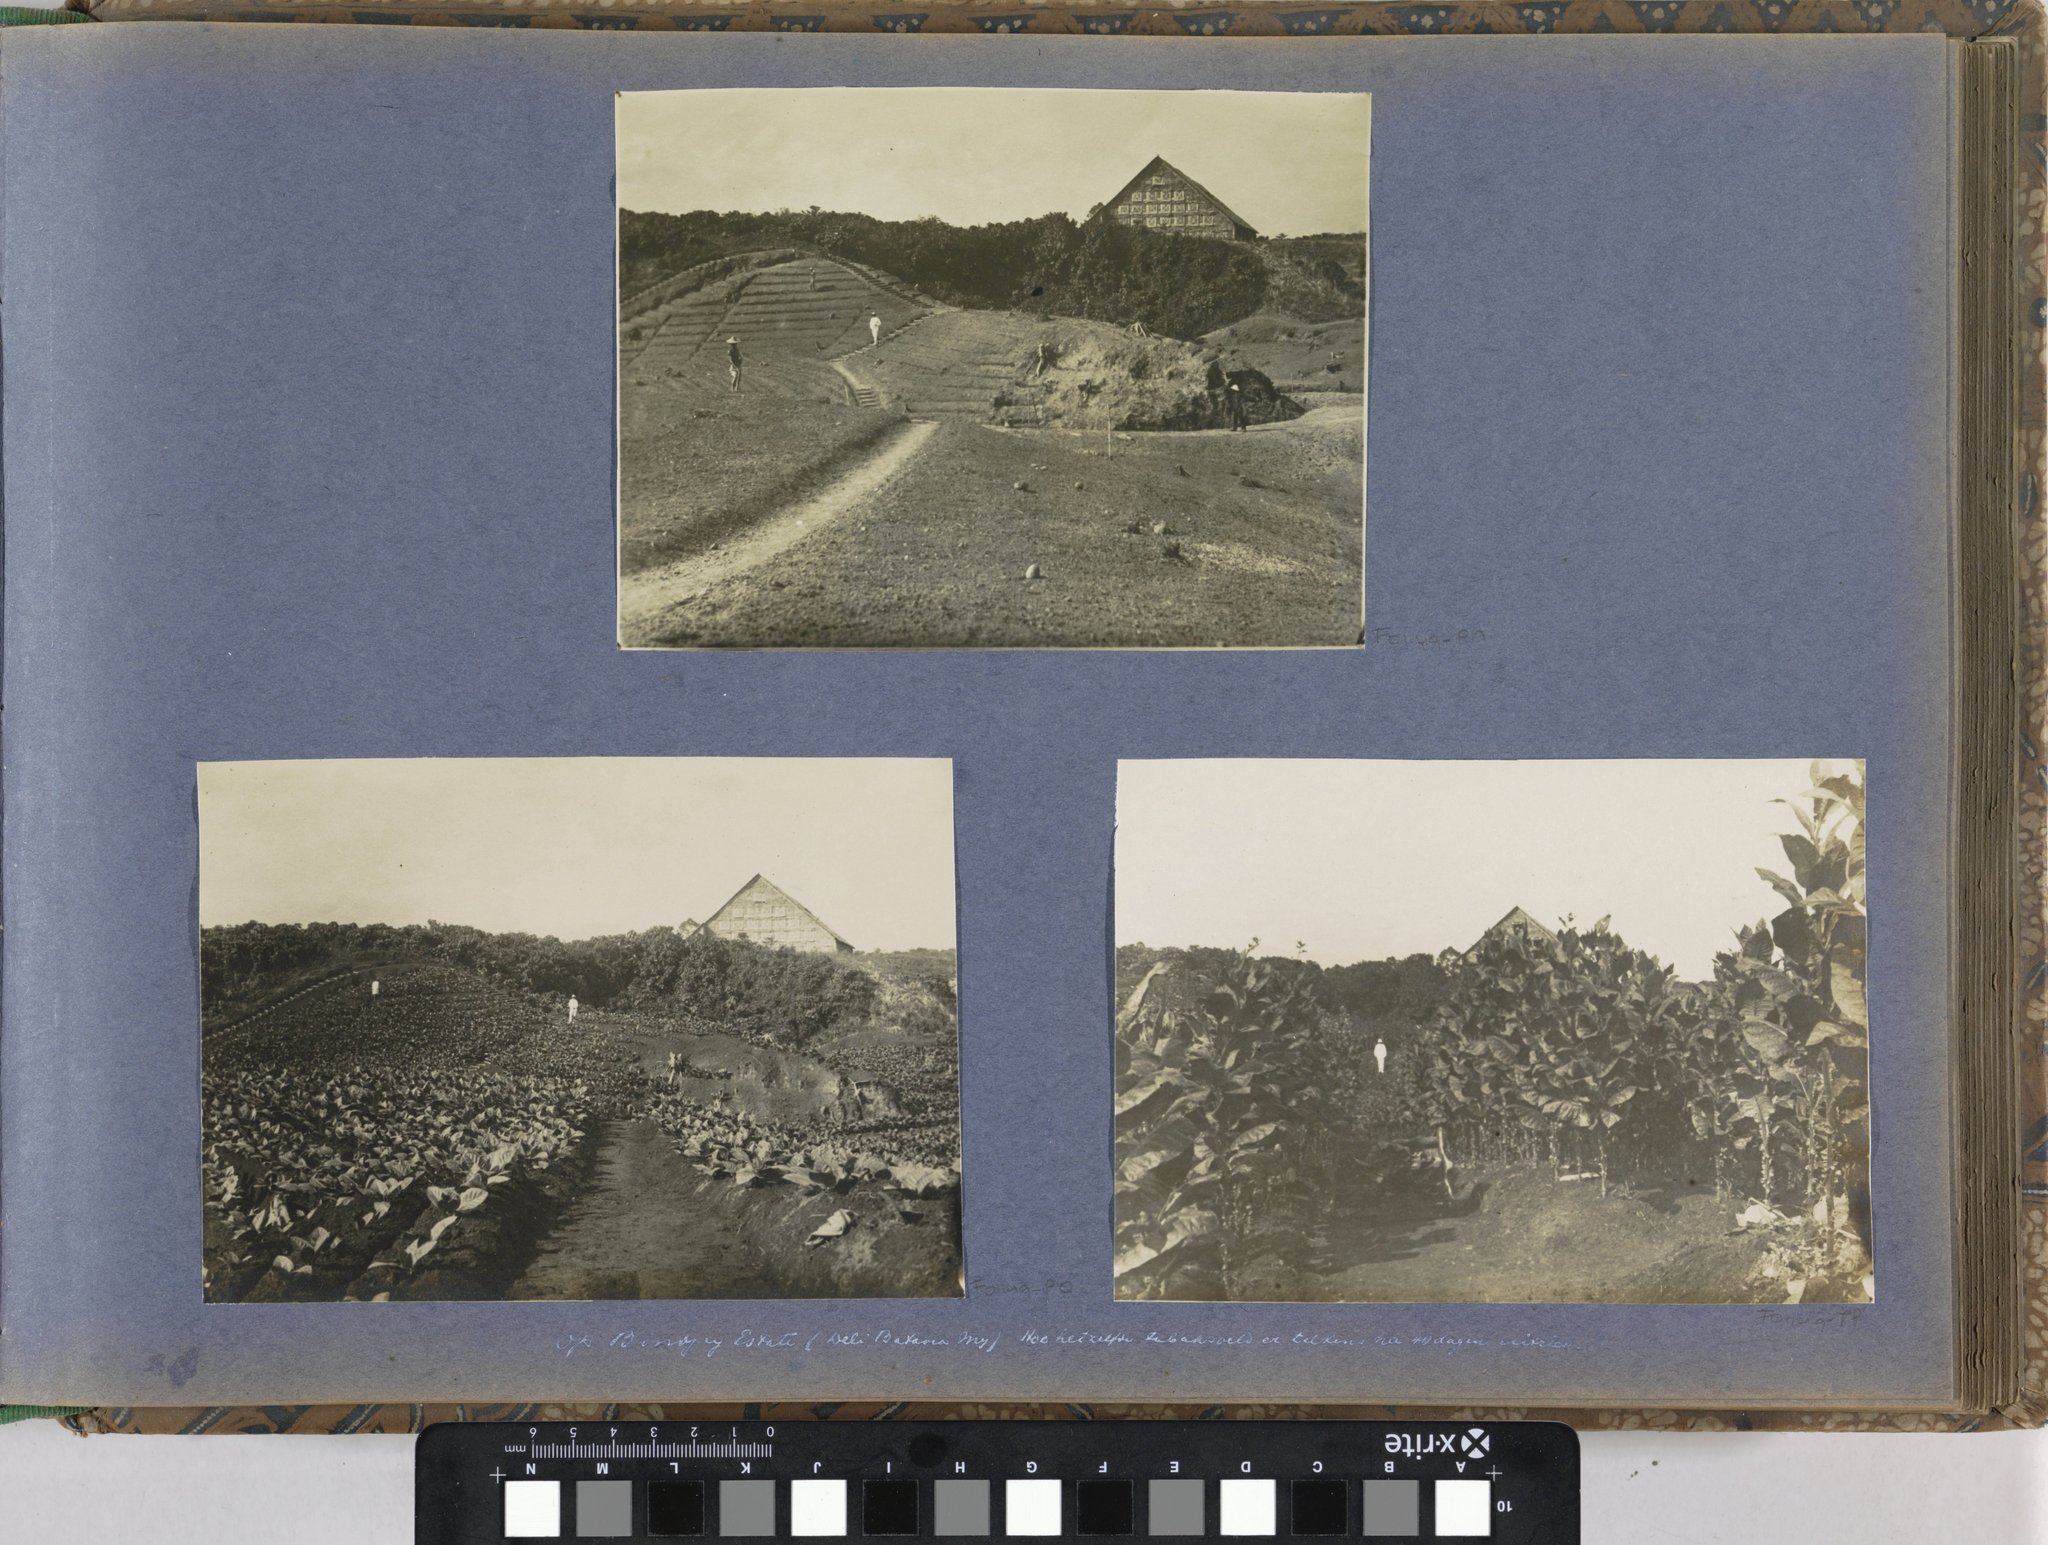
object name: album leaf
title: Tabaksveld op het Bindjey Estate van de Deli-Batavia Maatschappij op Sumatra (op dag van aanplant)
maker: Anonymous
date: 1900-1920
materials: paper, photographic support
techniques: gelatin silver print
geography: sumatra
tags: plantation, field filled with a crop, tobacco, sumatra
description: Foto 1 uit serie van 3. Onderdeel van reisalbum met foto's van bedrijvigheid en bezienswaardigheden op Sumatra en Java en van de reis naar en van Nederlands-Indië.